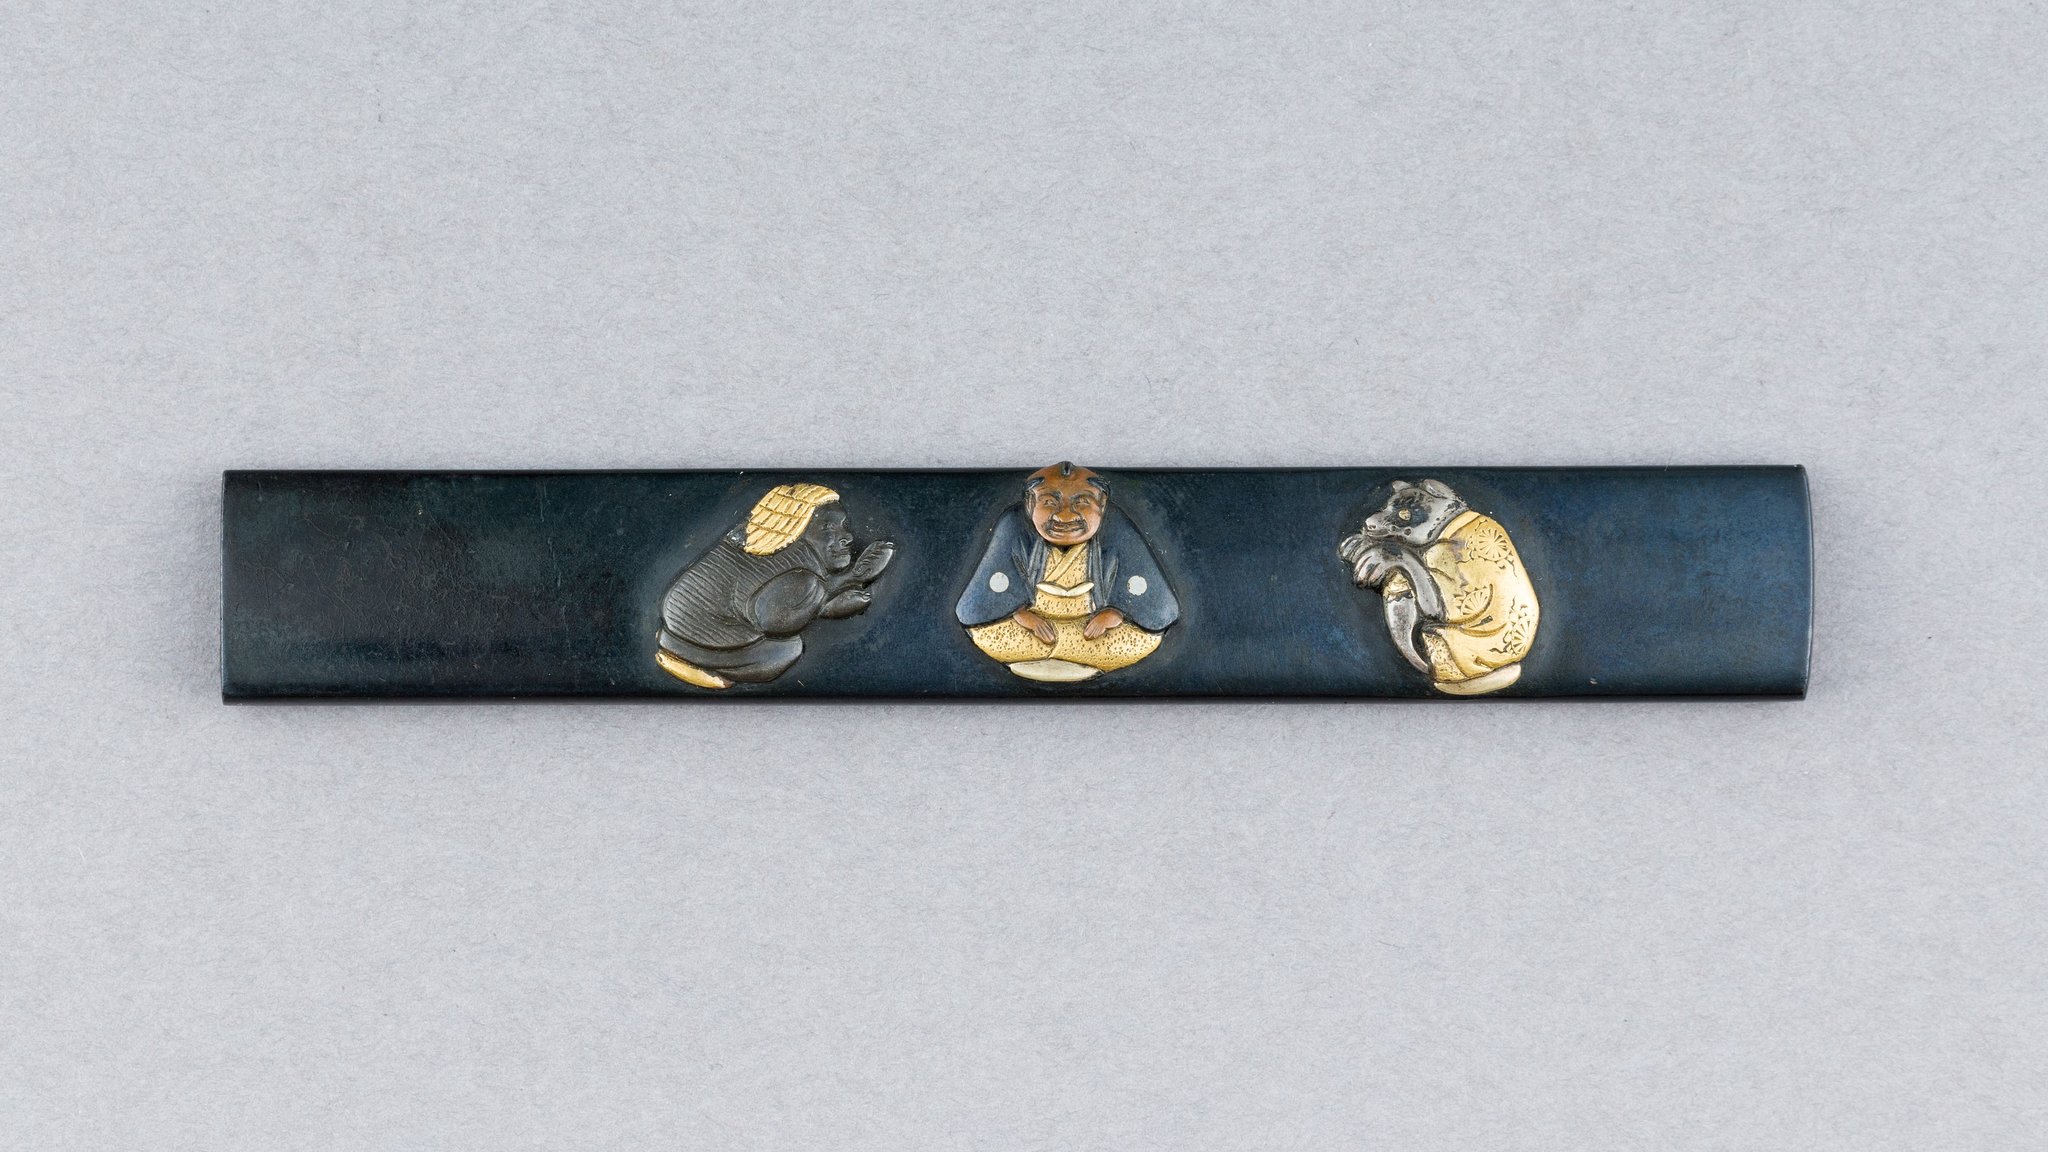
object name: knife handle kozuka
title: Knife Handle (Kozuka)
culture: japanese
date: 1615-1868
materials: copper, gold alloy, silver alloy, gold, silver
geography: japan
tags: animals,men